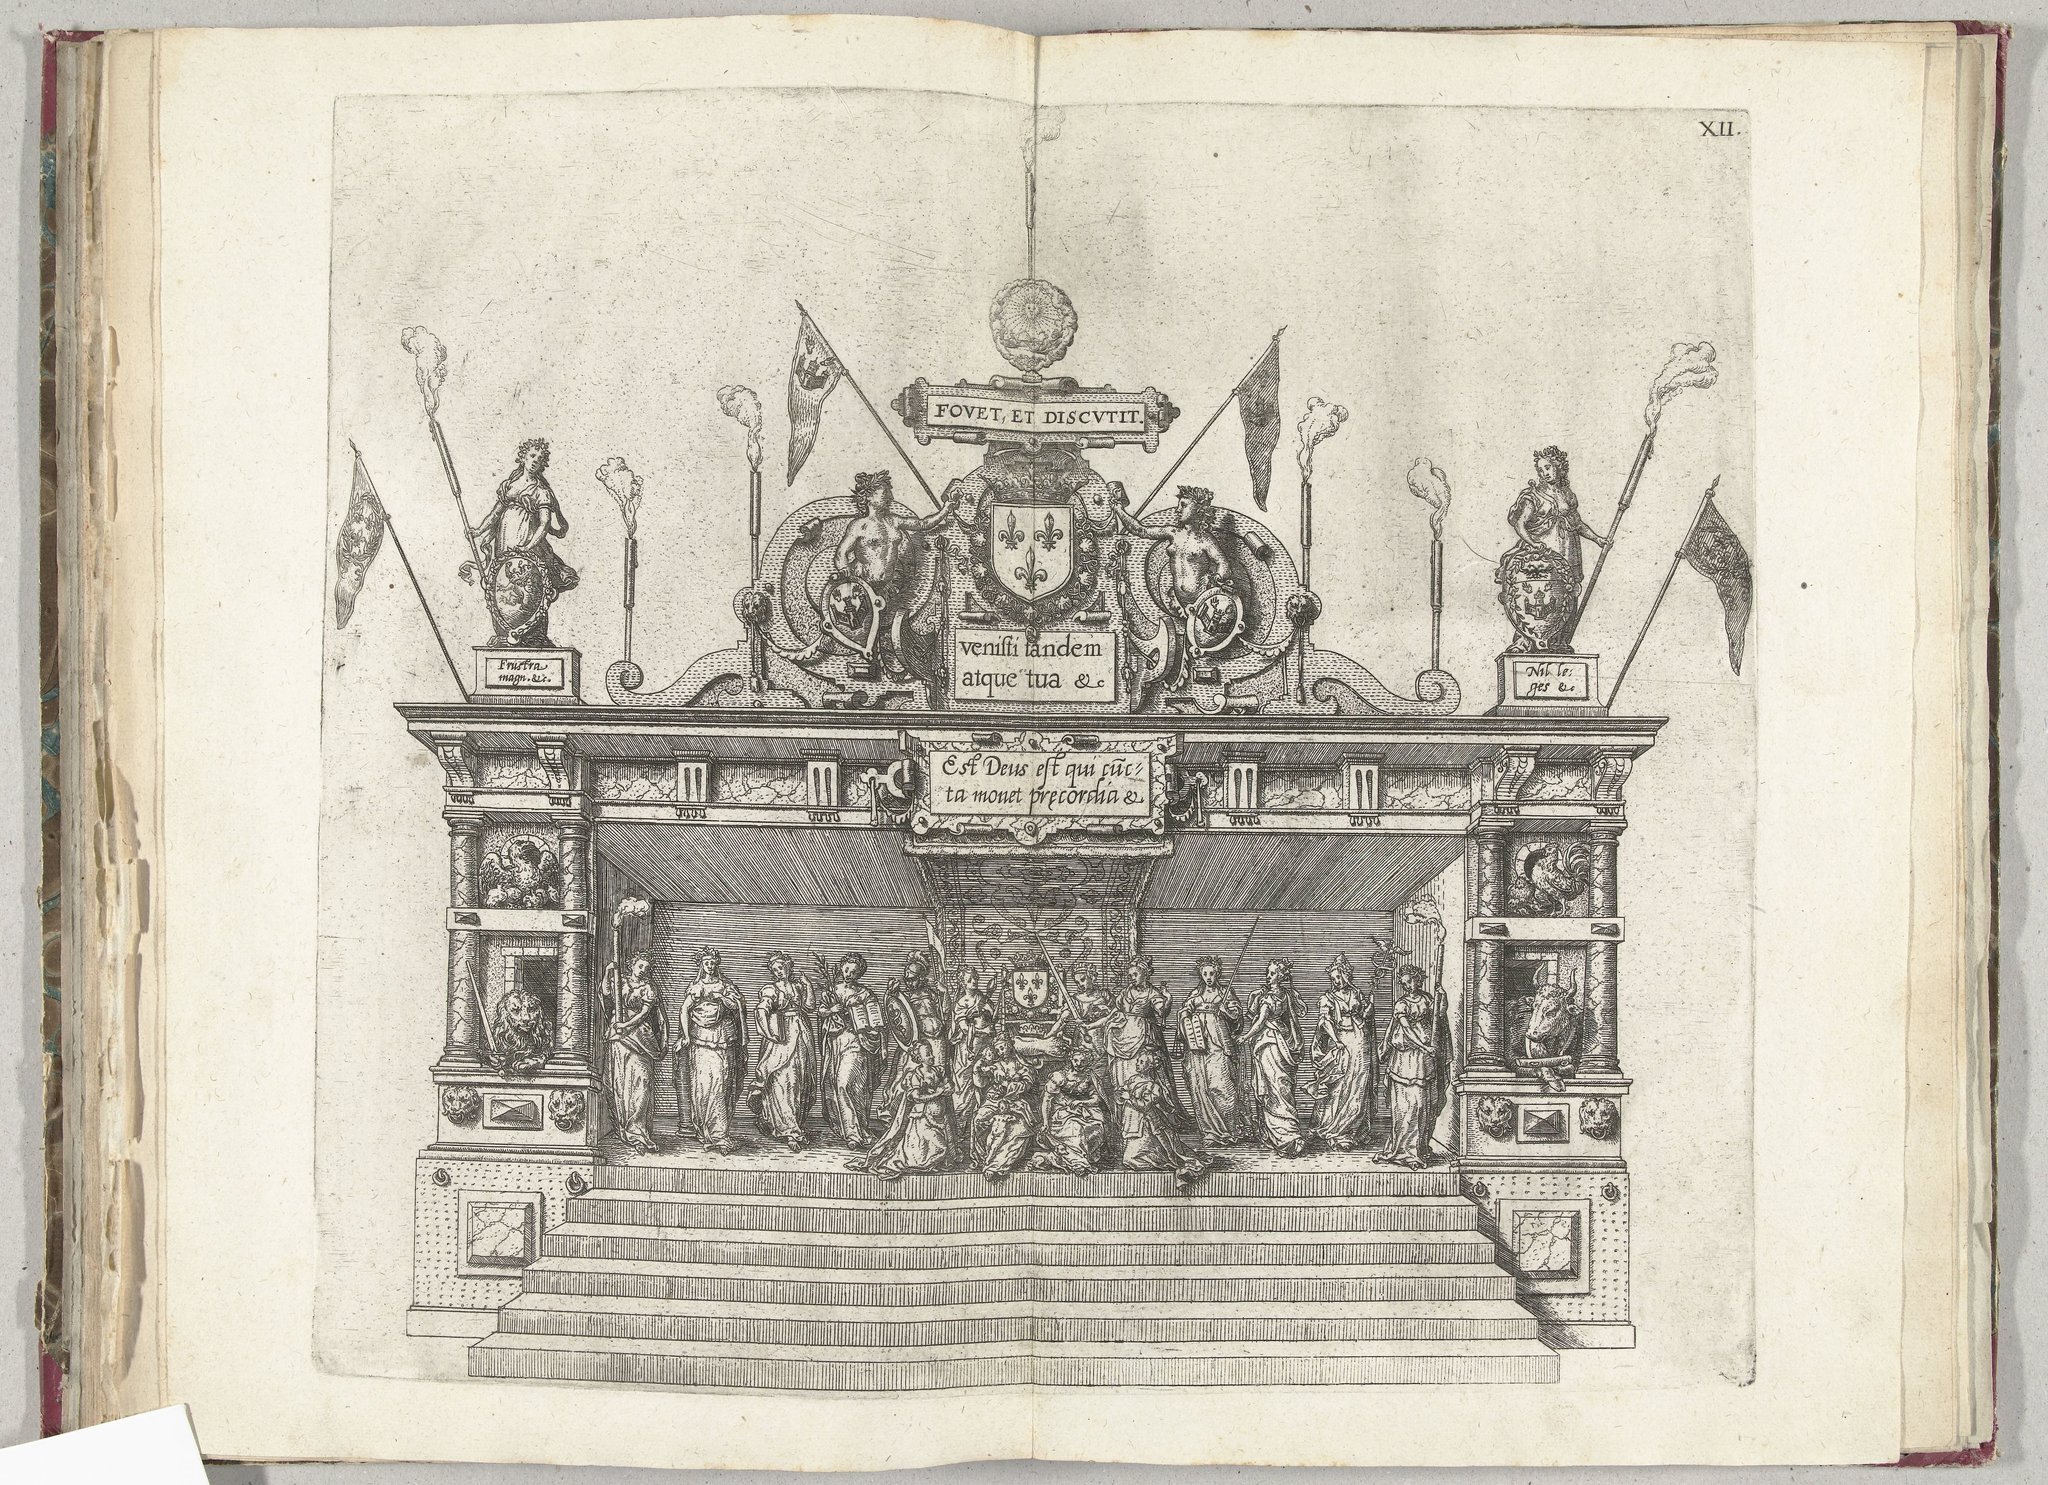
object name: print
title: Toneel met de lege troon omringd door deugden en nimfen, 1582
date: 1582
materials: paper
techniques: etching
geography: netherlands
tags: françois-hercule de valois (hertog van anjou), group of actors, troupe; actors on the stage, triumphal entry and public reception, pageant, 'entrée solennelle', 'joyeuse entrée', antwerp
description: Illustratie in: La ioyeuse et magnifique entrée de Françoys ... Duc de Brabant, d'Anjou, Alençon, Berri et c. en sa tres-renommée ville d'Anvers, Christoffel Plantijn, Antwerpen 1582, pl. XII. Boek in de Rijksmuseum Research Library met signatuur: 327 I 8.